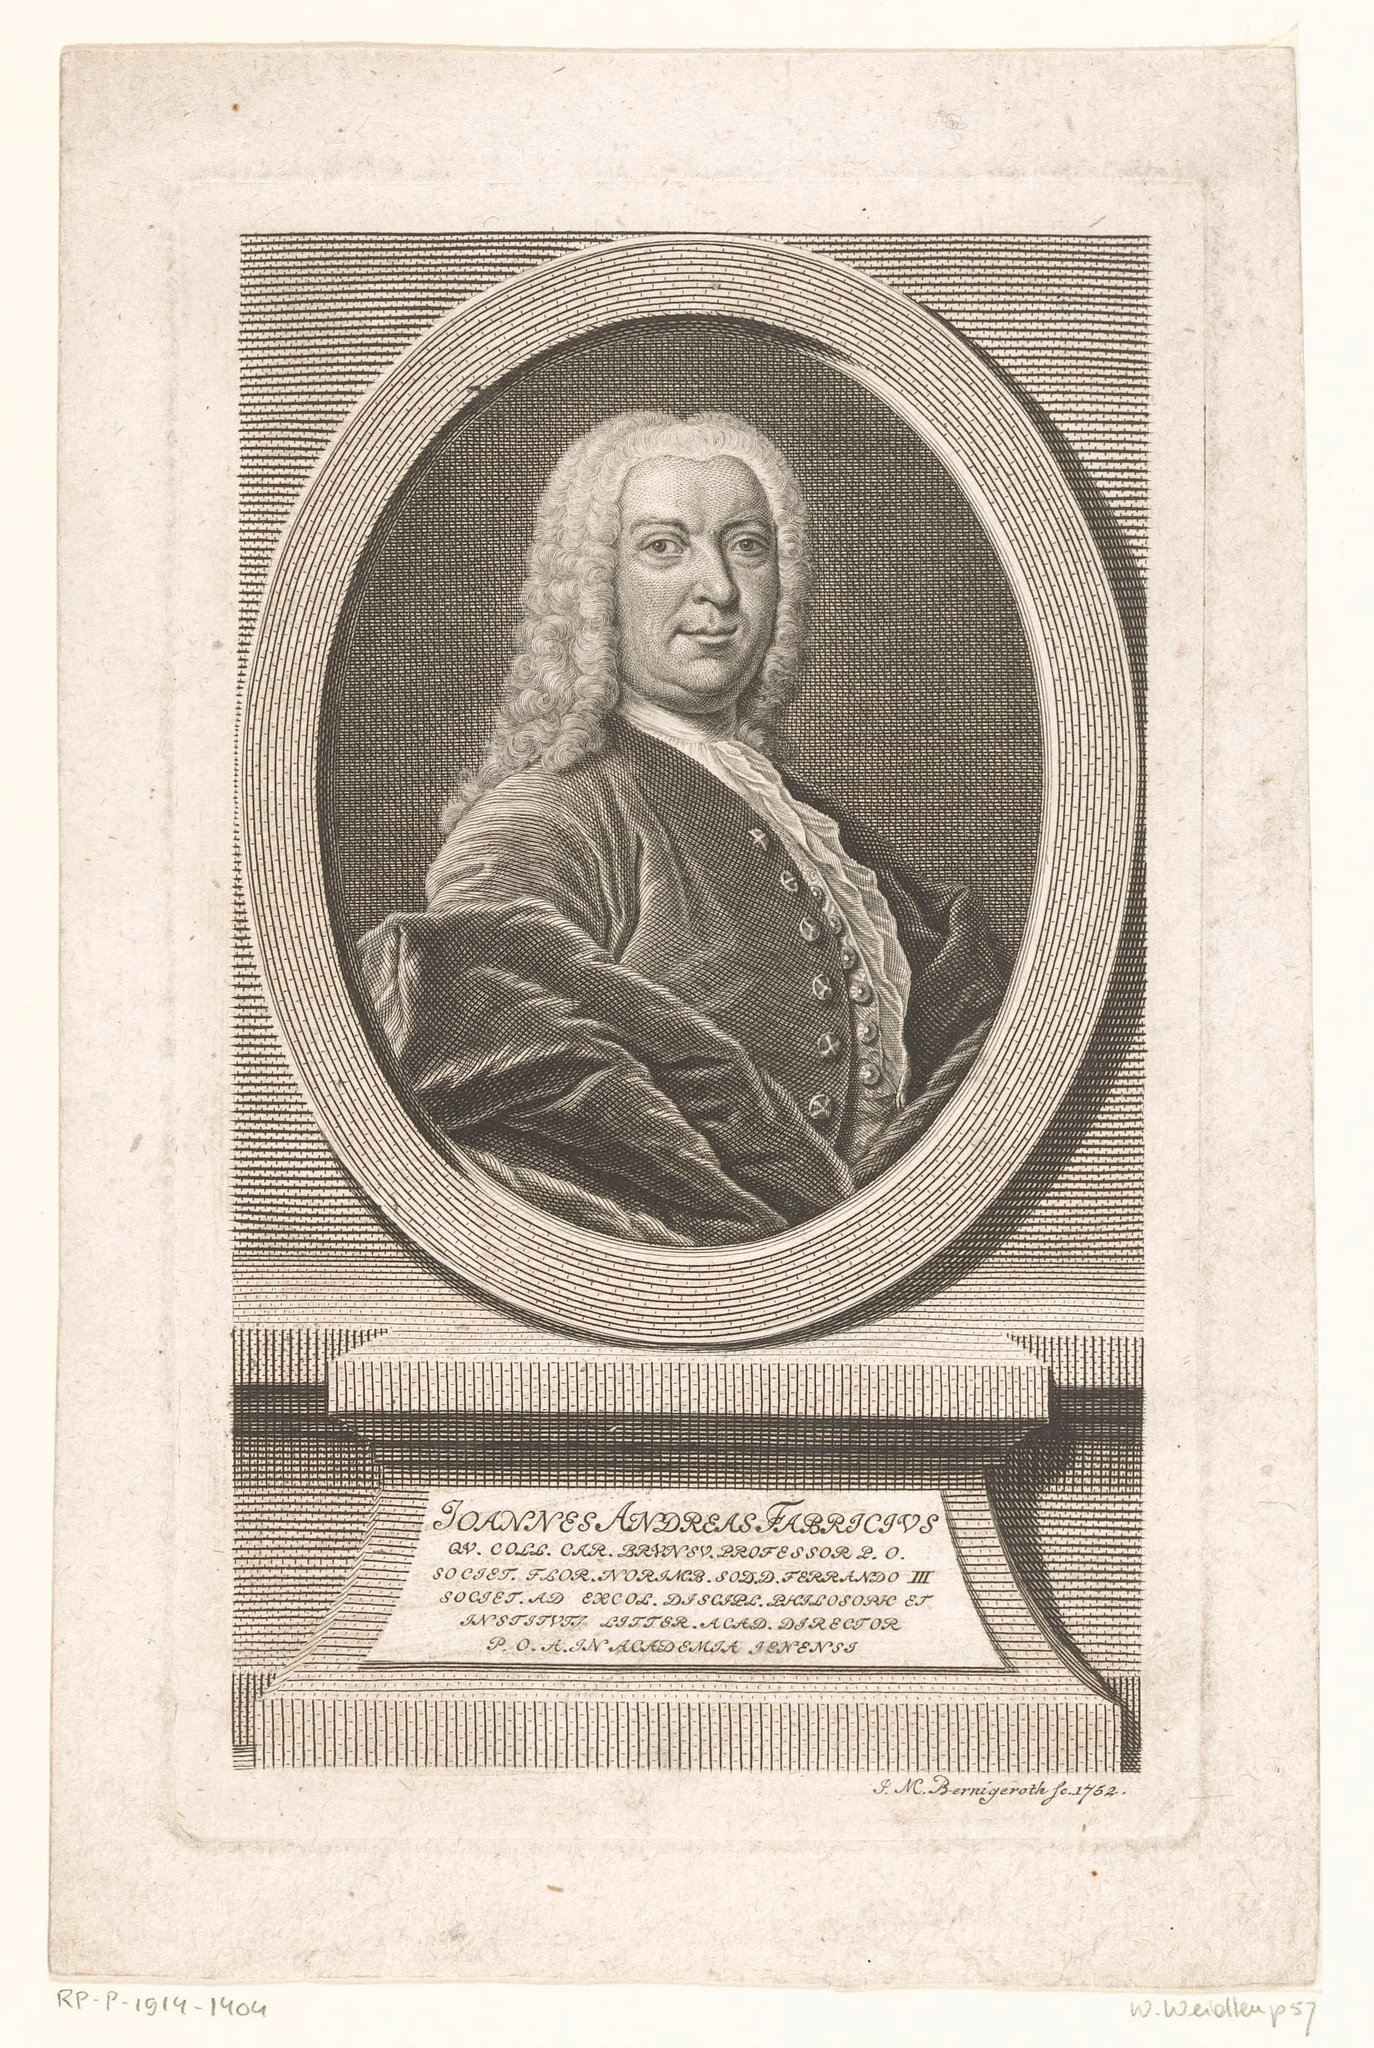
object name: print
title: Portret van Johann Andreas Fabricius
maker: johann martin bernigeroth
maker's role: print maker, publisher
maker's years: 1713-1767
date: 1752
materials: paper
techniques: engraving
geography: leipzig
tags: historical persons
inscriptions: collector's mark: Lugt 2228, collector's mark: Lugt 358